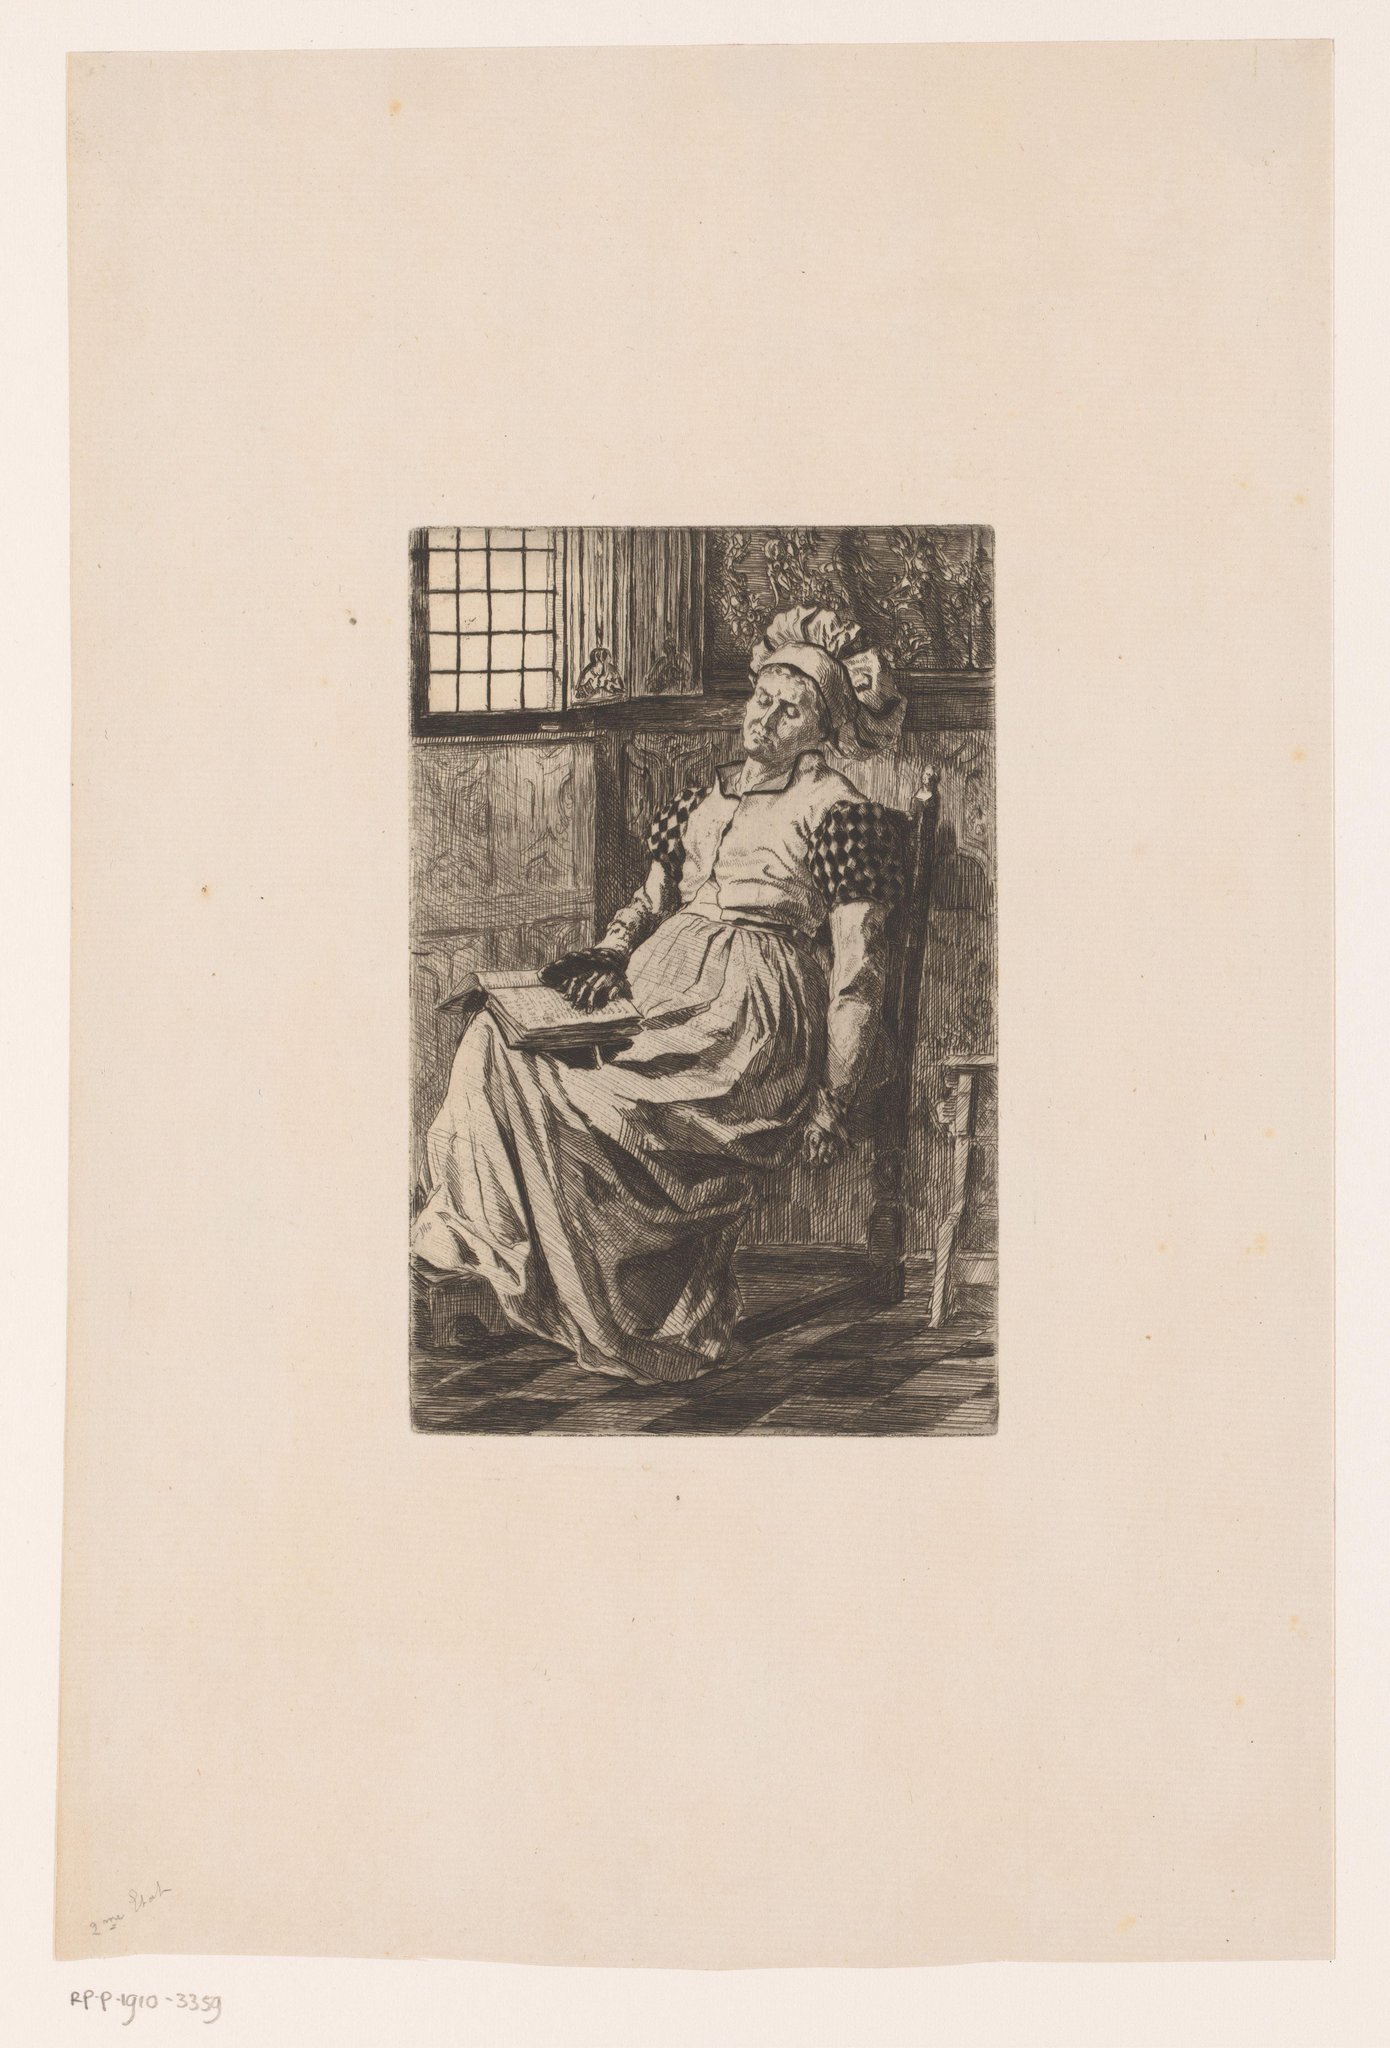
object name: print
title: Slapende vrouw op een stoel met boek op schoot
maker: willem geets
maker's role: print maker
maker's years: 1838-1919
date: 1848-1910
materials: paper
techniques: etching, intaglio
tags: sleeping in chair, book - mm - book open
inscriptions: collector's mark: Lugt 2228